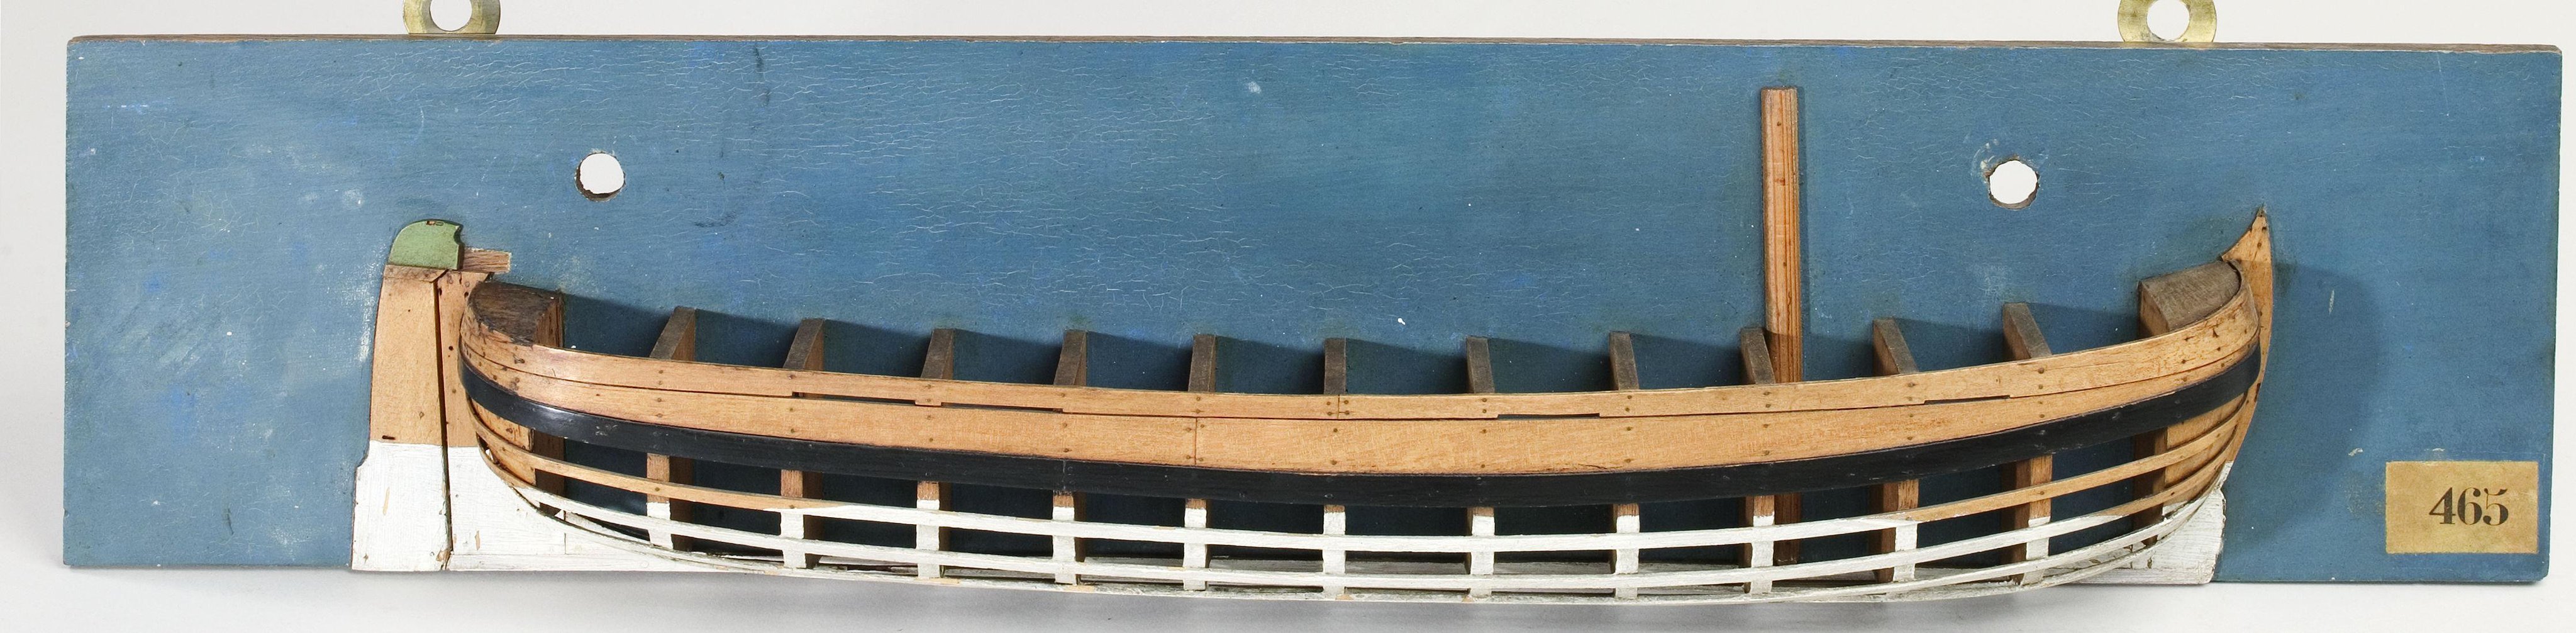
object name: builder's model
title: Half Model of a Tjalk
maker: Anonymous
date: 1780-1820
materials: wood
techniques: polychromy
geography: netherlands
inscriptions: label, bottom right: ‘465’ former inventory label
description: Gepolychromeerd mallenmodel (stuurboord) van een eenmast platbodem. De huid boven het barkhout is gesloten en heeft vier lange spuigaten. Rond achterschip, breed roer. De zeeg loopt naar beide uiteinden op, een barkhout.